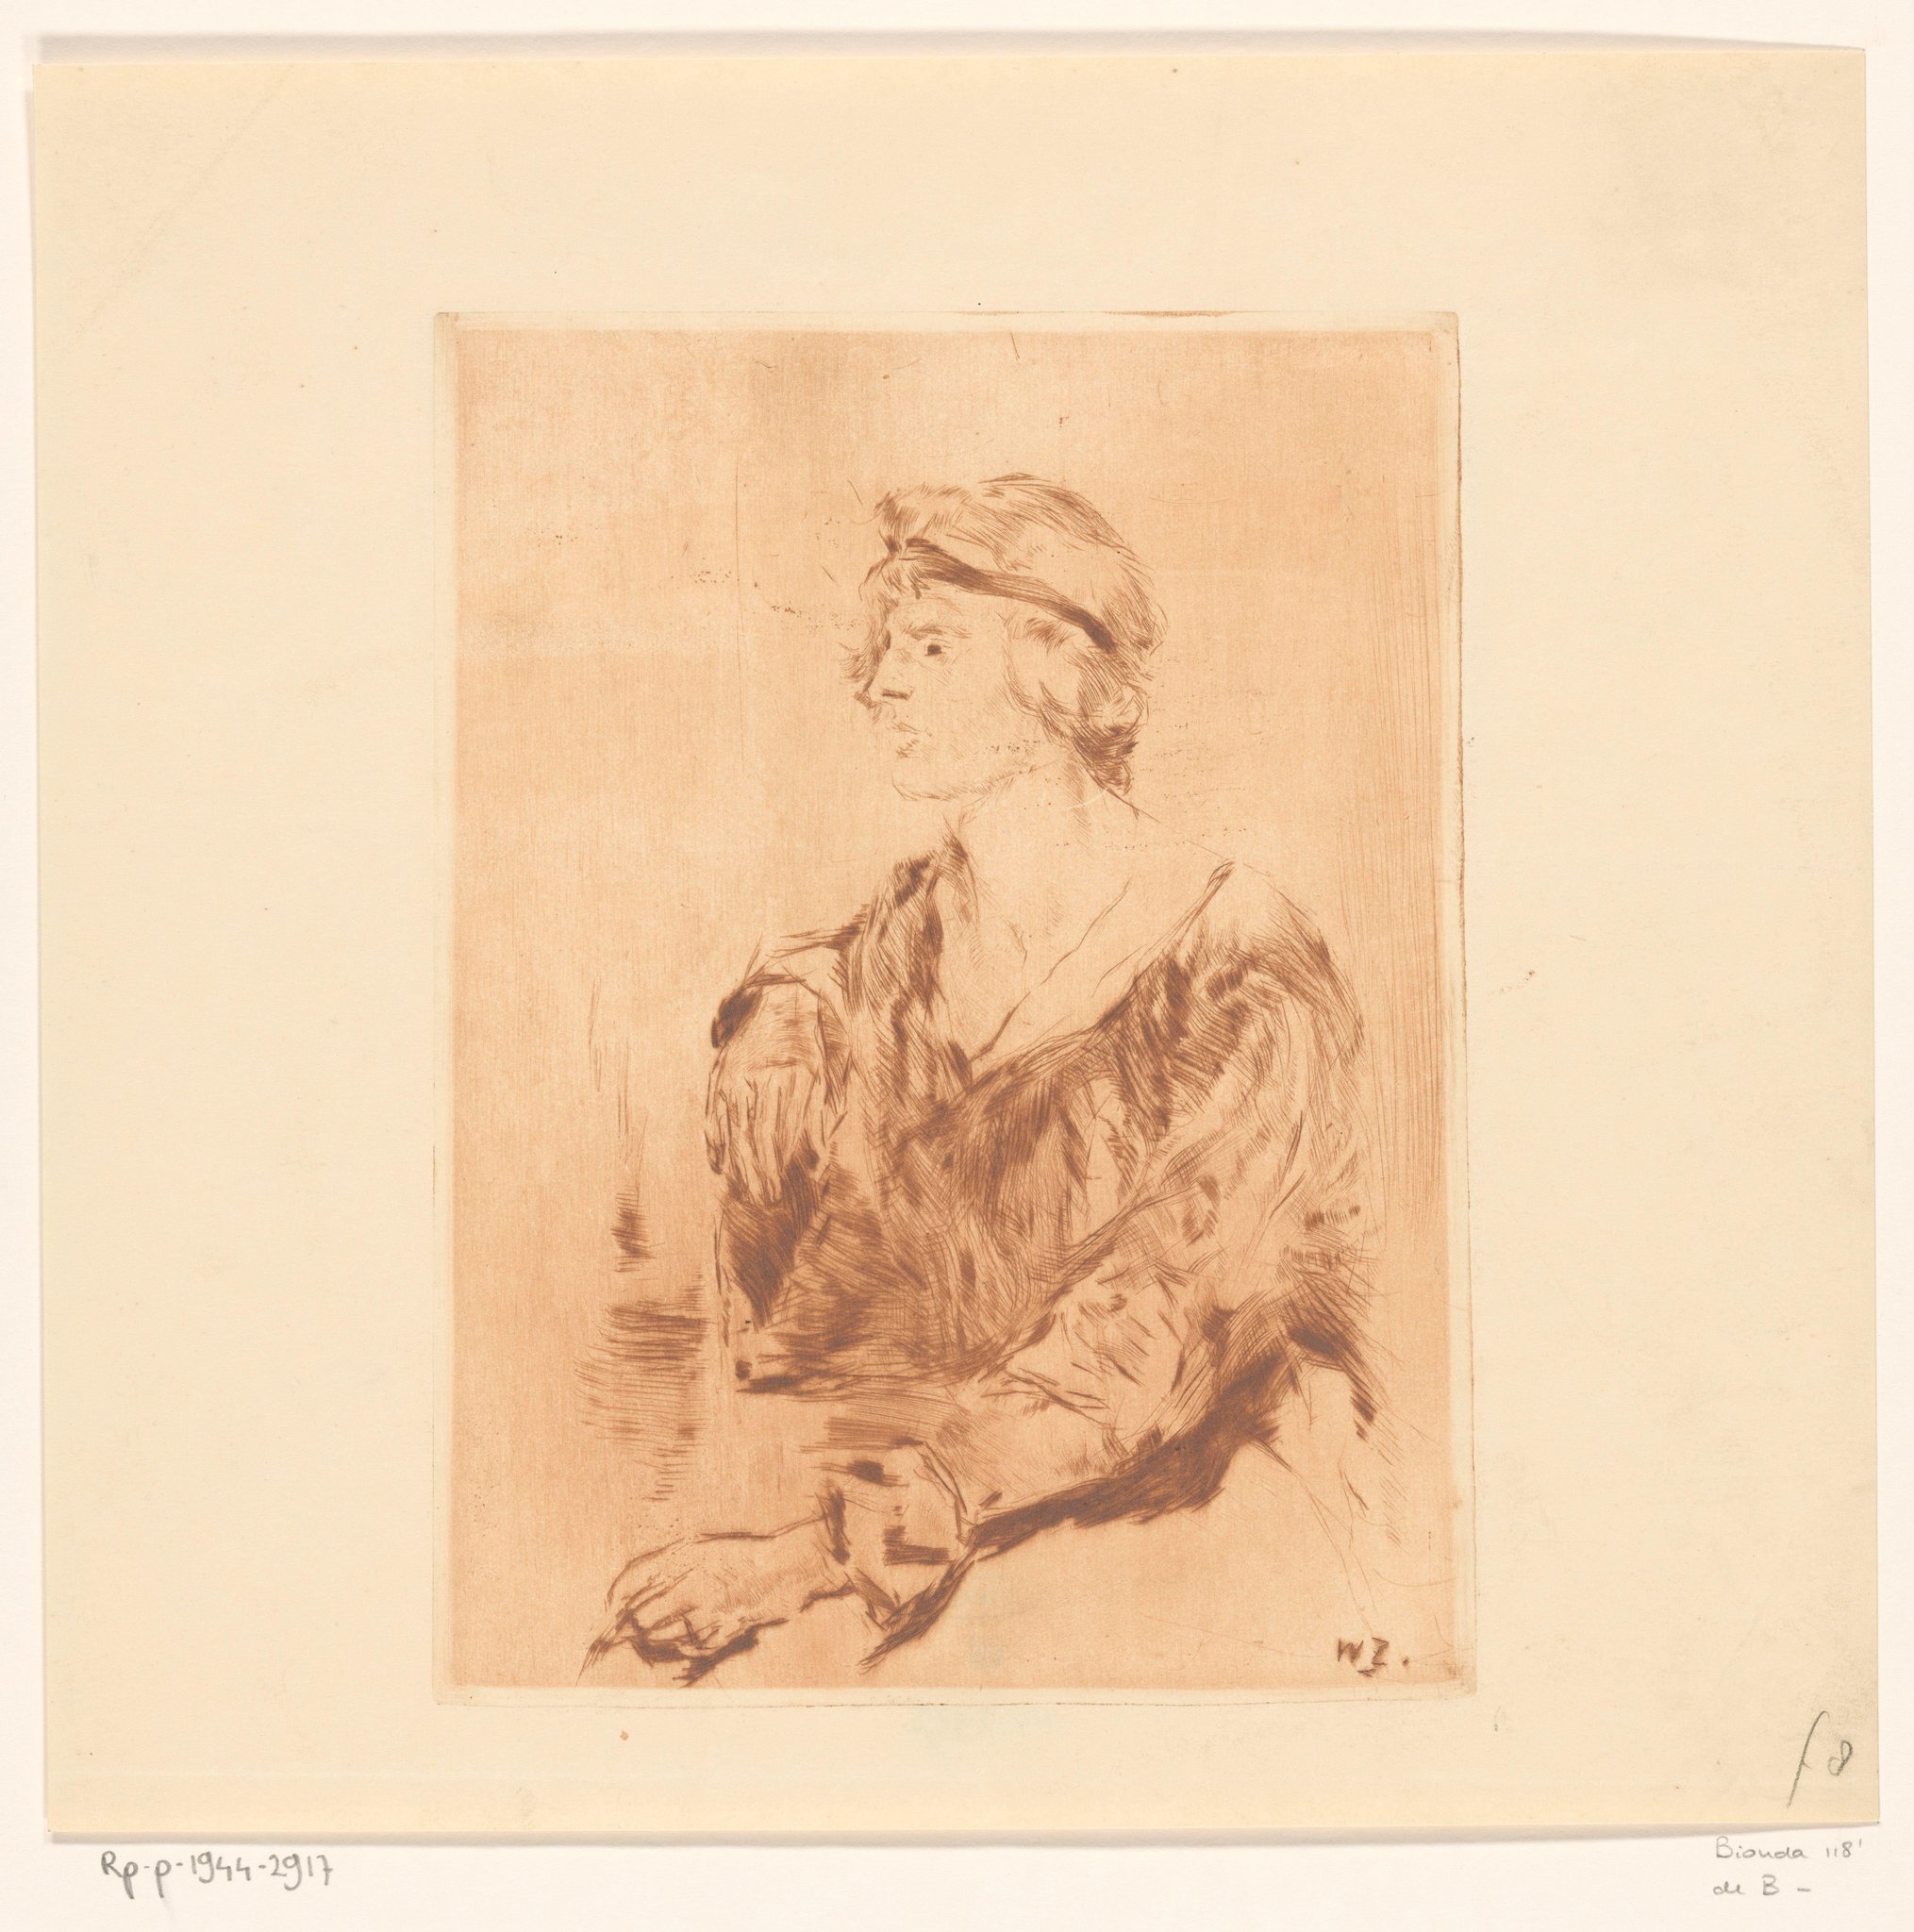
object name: print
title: Zittende vrouw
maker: willem de zwart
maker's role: draughtsman, painter, print maker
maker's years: 1862-1931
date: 1915-1916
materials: paper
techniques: drypoint, intaglio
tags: adult woman, historical persons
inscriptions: collector's mark: Lugt 2228, collector's mark: Lugt 2760